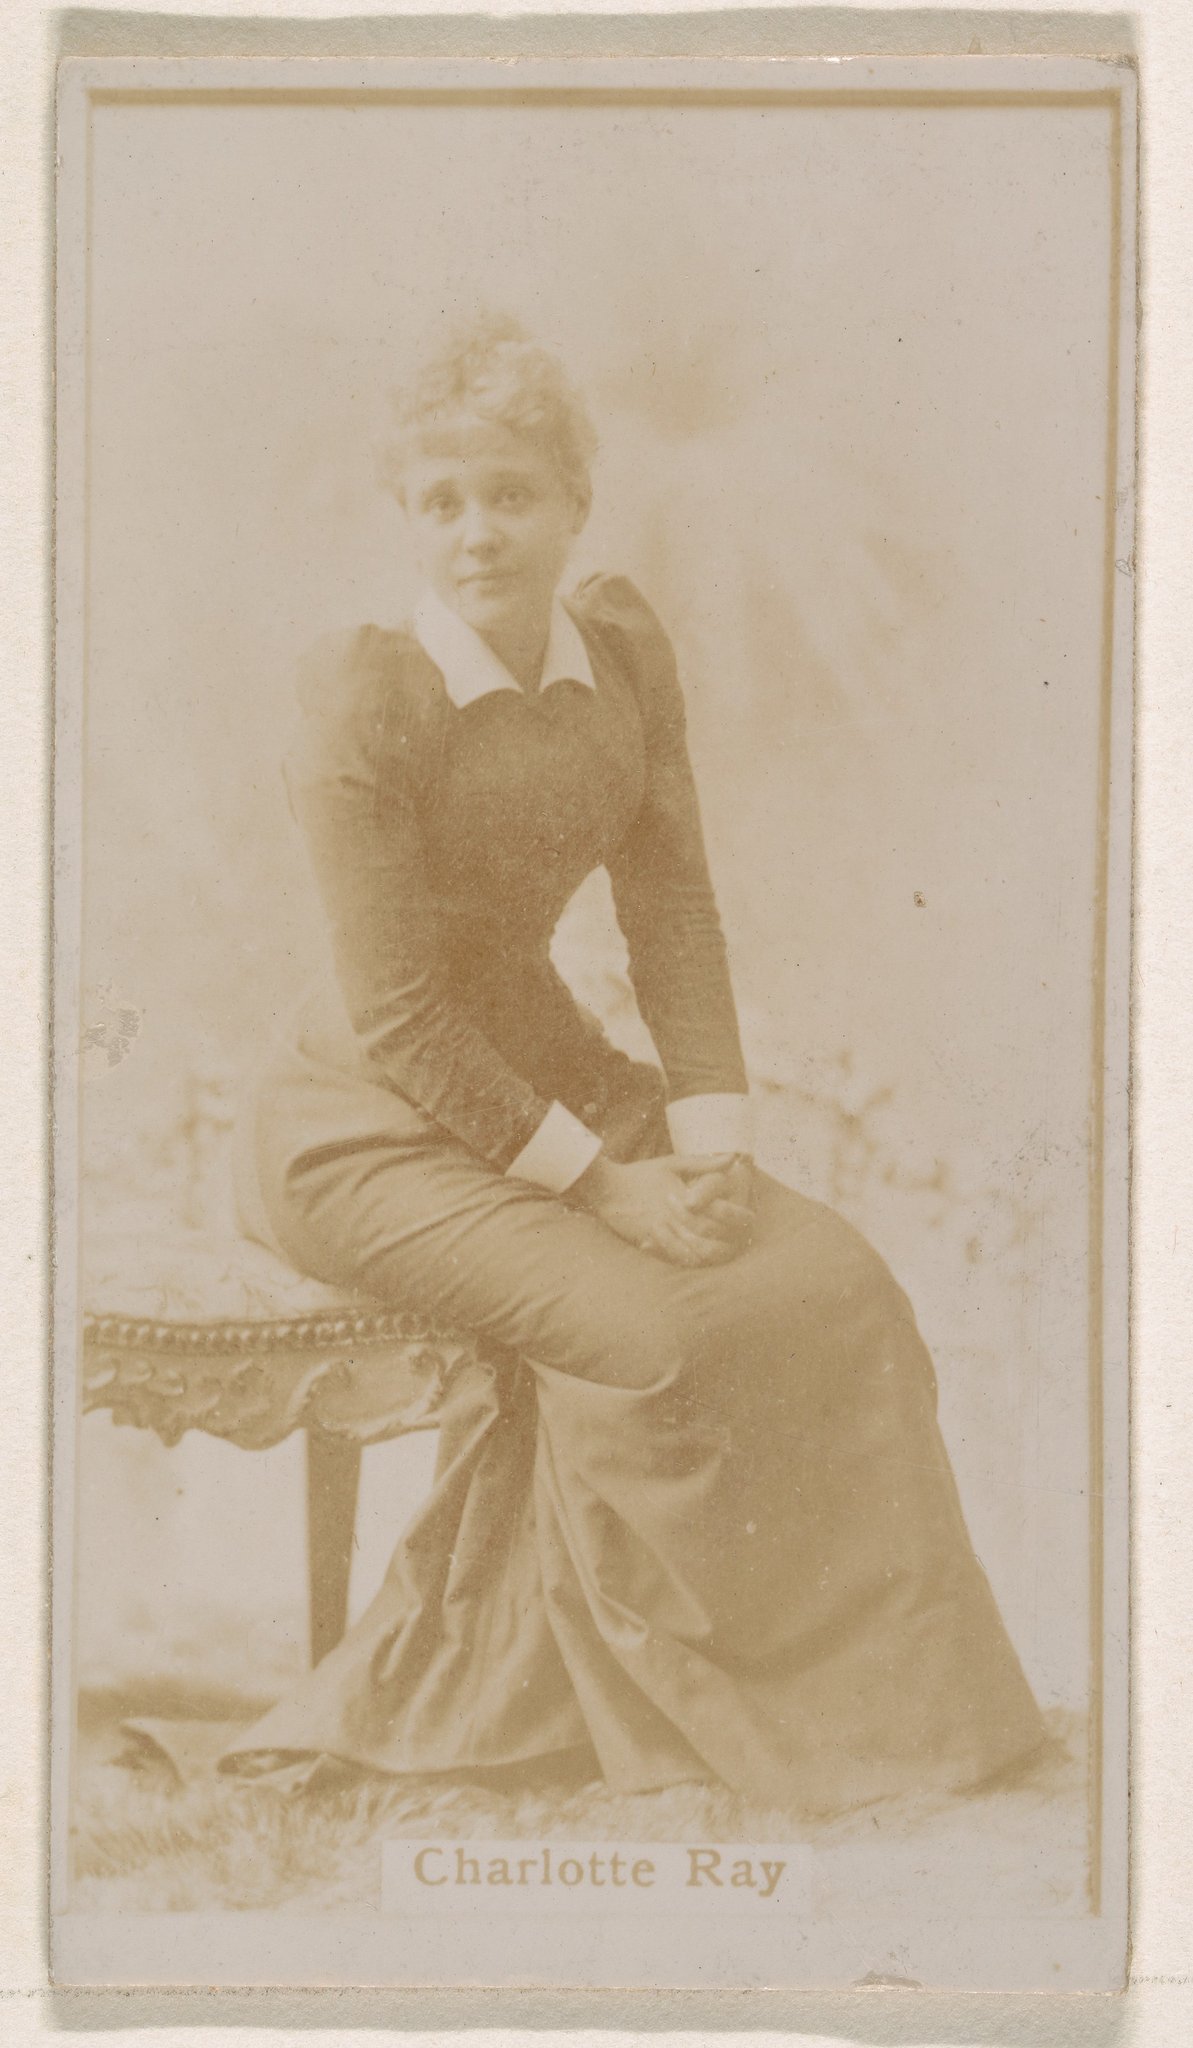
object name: photograph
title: Charlotte Ray, from the Actresses series (N245) issued by Kinney Brothers to promote Sweet Caporal Cigarettes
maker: kinney brothers tobacco company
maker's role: publisher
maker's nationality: american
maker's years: 1869-2011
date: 1890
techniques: albumen silver print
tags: portraits,women,actresses